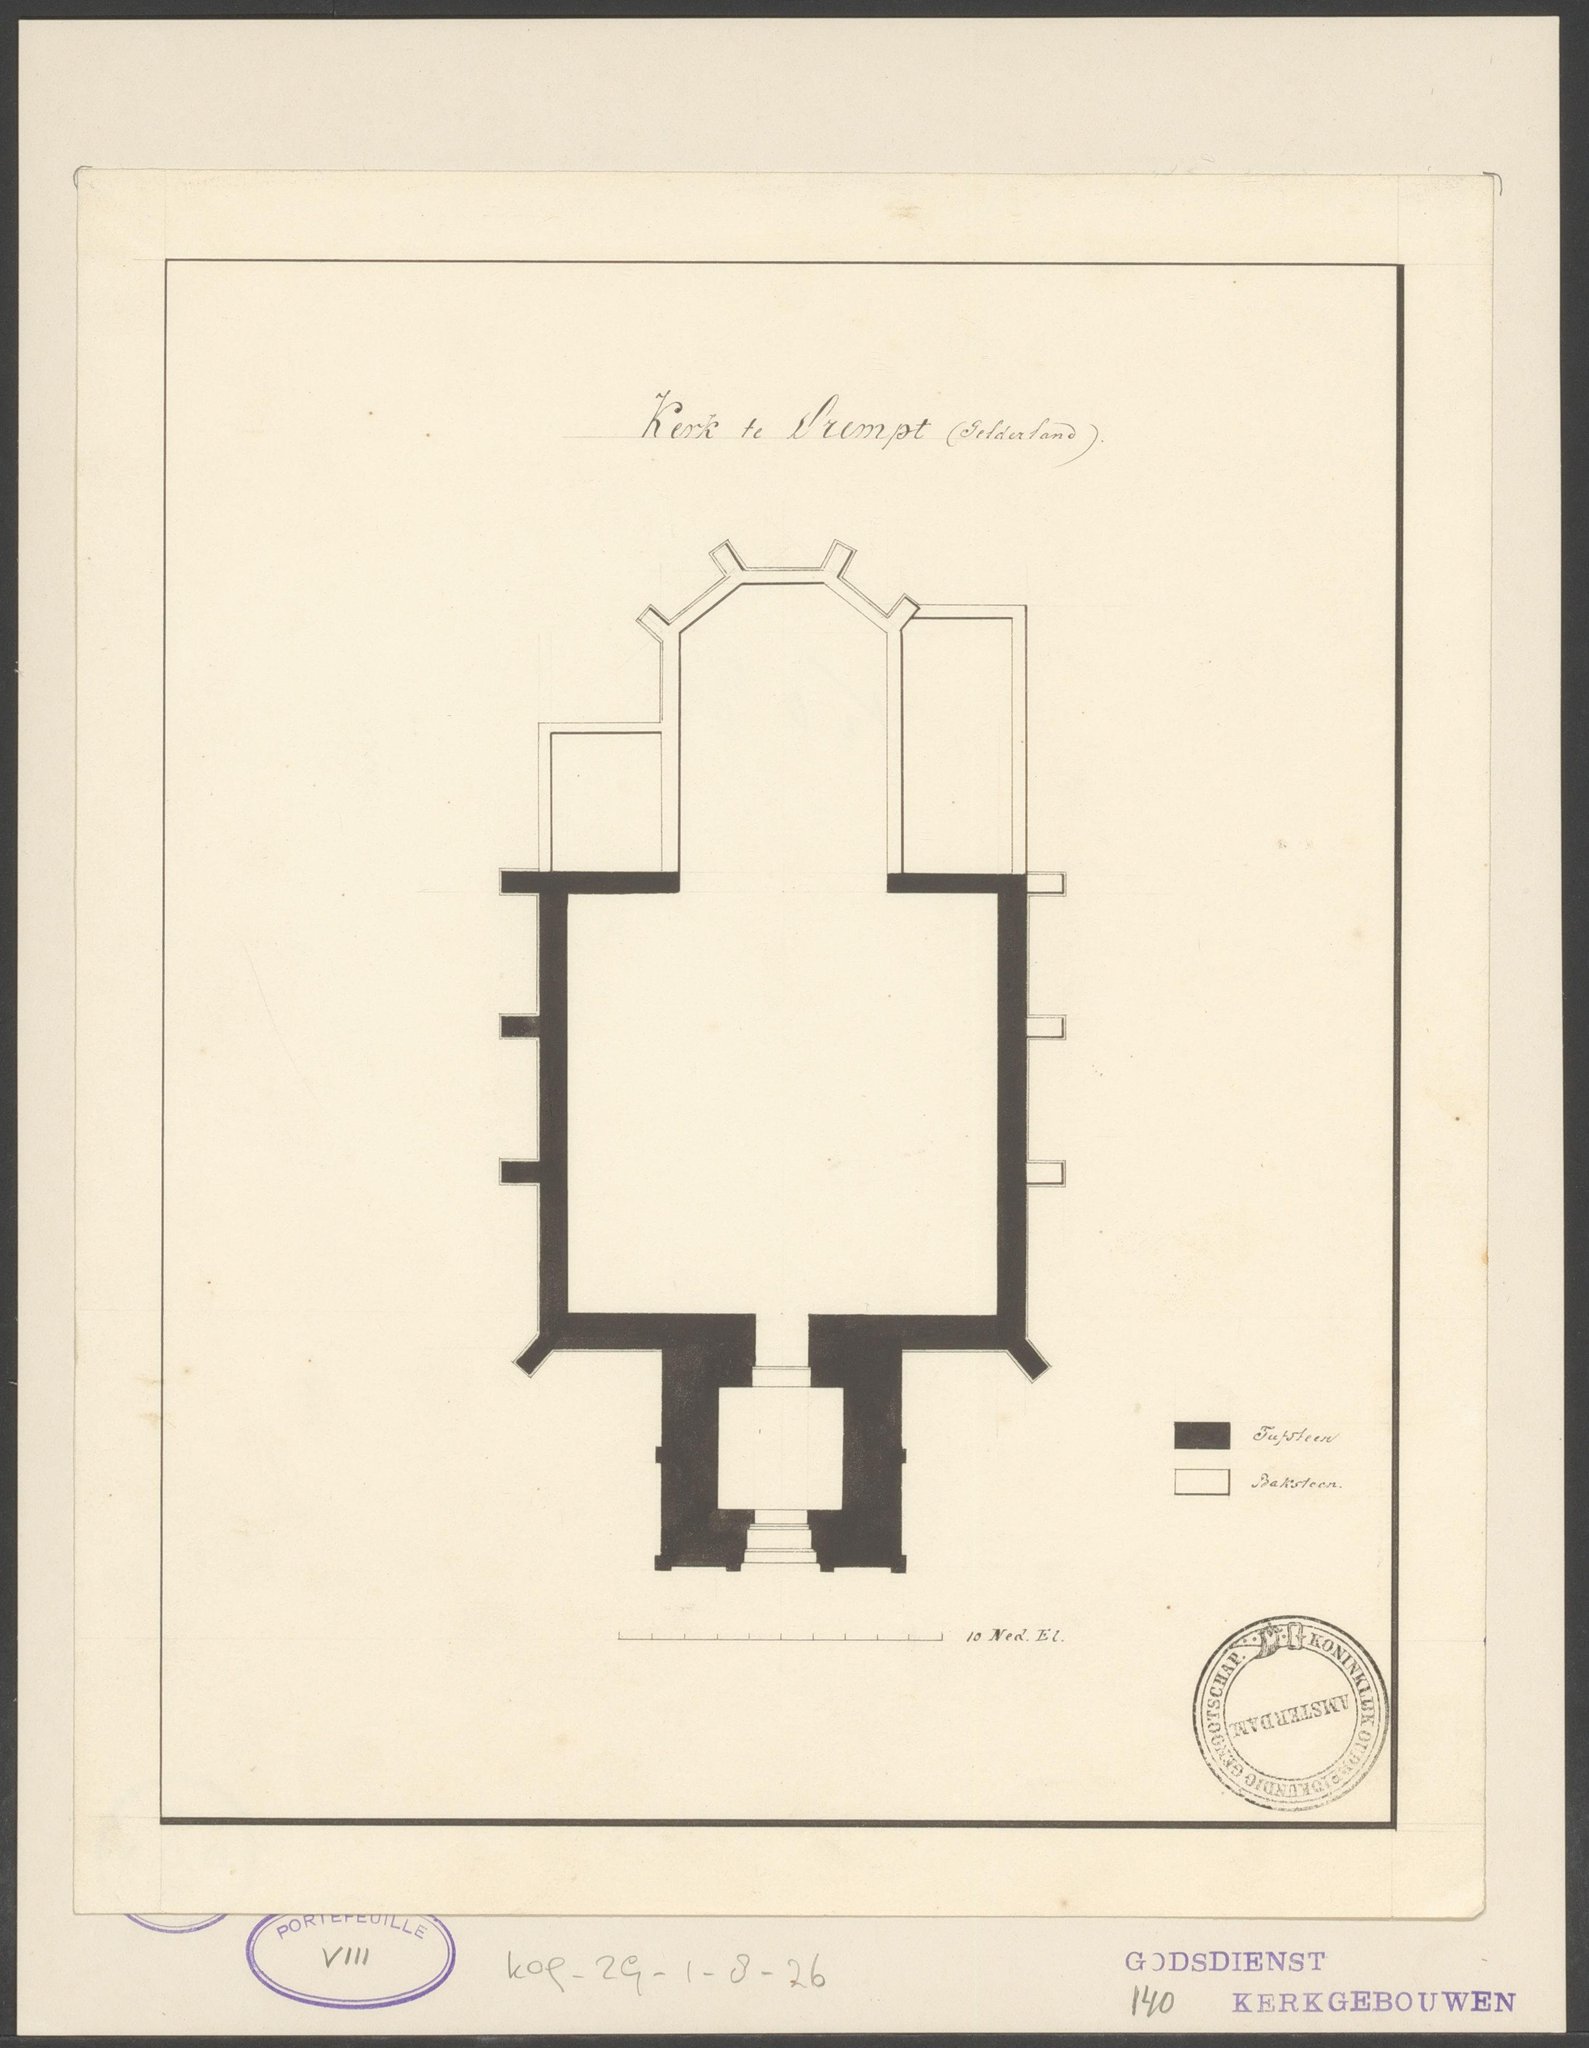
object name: drawing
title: Kerk te Drempt (Gelderland)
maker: Anonymous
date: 1800-1899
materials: ink, paper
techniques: brush, pen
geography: netherlands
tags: interior of church, plan ~ architecture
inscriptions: collector's mark: Lugt 1641, collector's mark, collector's mark:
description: Getekende plattegrond van een kerk te Drempt. Waarschijnlijk gaat het om de Hervormde kerk, ook wel de Sint-Joriskerk, in Voor-Drempt. Met aanduiding van de gebruikte stenen en onderaan een schaalstok. Onderwerpsrubrieken binnen de Atlas Zeden en Gewoonten: Kerk en kerkwezen & Armwezen en liefdadige instellingen; Kerkgebouwen elders. A-E.